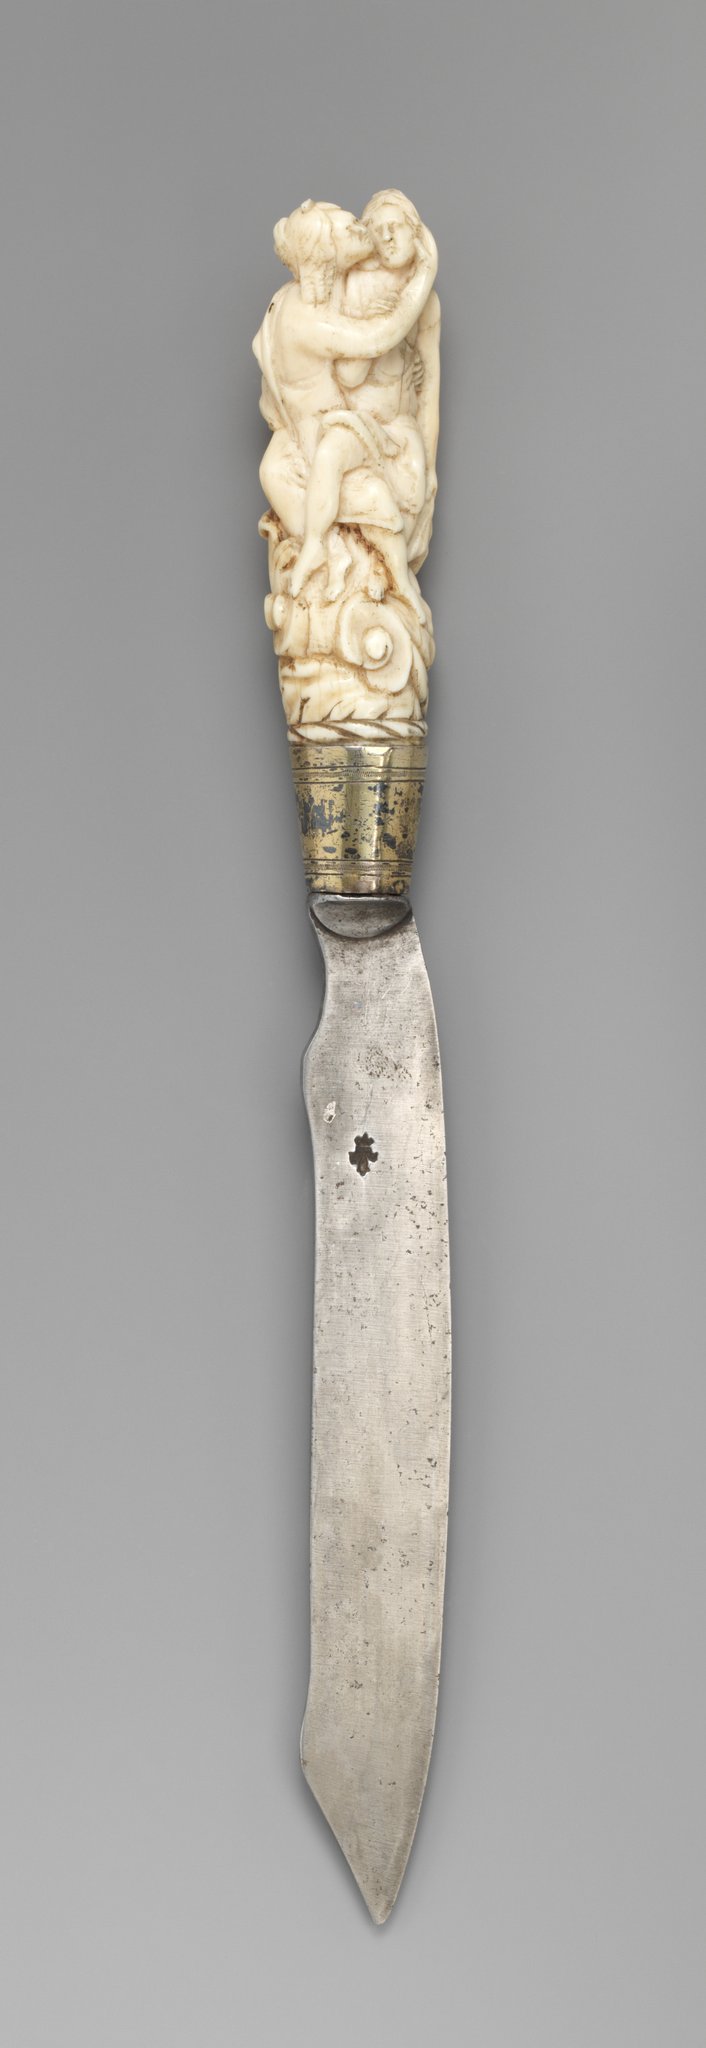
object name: pastry knife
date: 1601-1700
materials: brass, ivory, steel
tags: women